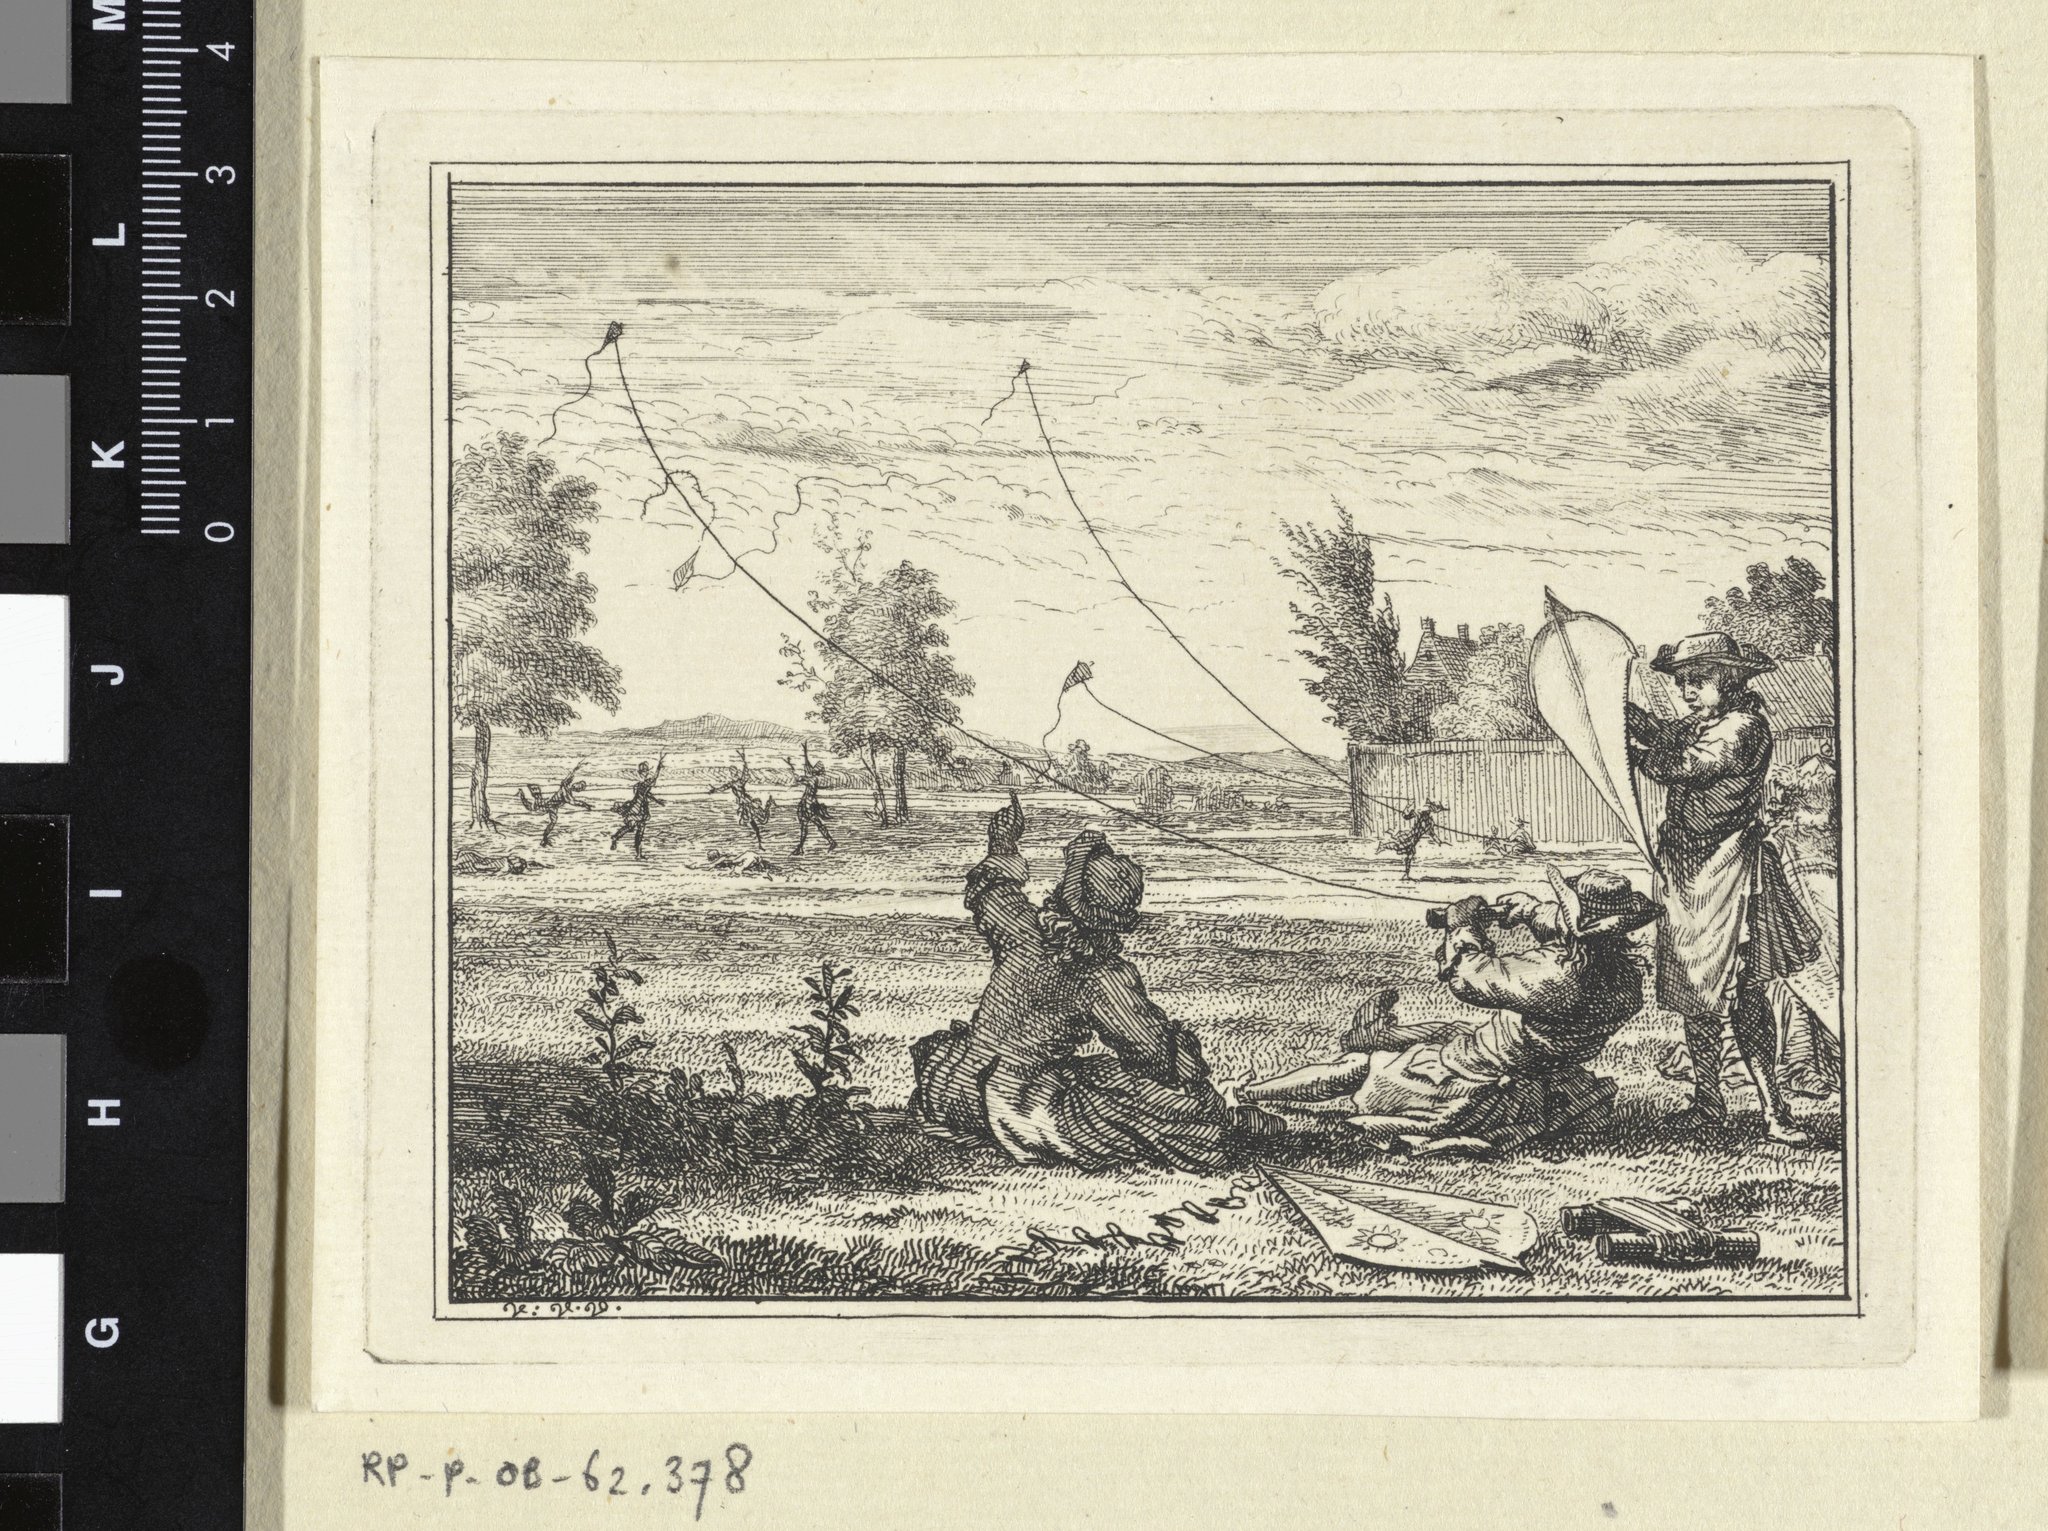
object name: print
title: Vliegeraars in een landschap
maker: vincent laurensz. van der vinne (ii)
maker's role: draughtsman, print maker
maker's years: 1686-1742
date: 1714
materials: paper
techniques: etching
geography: haarlem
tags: (flying a) kite, binoculars, spy-glass, etc.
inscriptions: collector's mark: Lugt 240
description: Prent oorspronkelijk bedoeld als boekillustratie voor: Spinniker, Adriaan. Leerzaame zinnebeelden. Haarlem: [boekverkoper] Isaak van der Vinne (I) en Amsterdam: [drukker] Johannes Krelius, 1714. Later gebruikt als boekillustratie in: Spinniker, Adriaan. Vervolg der leerzaame zinnebeelden, : spiegel der boetvaardigheid en genade en eenige Stichtelyke gezangen. Haarlem: Jan Bosch, 1758.